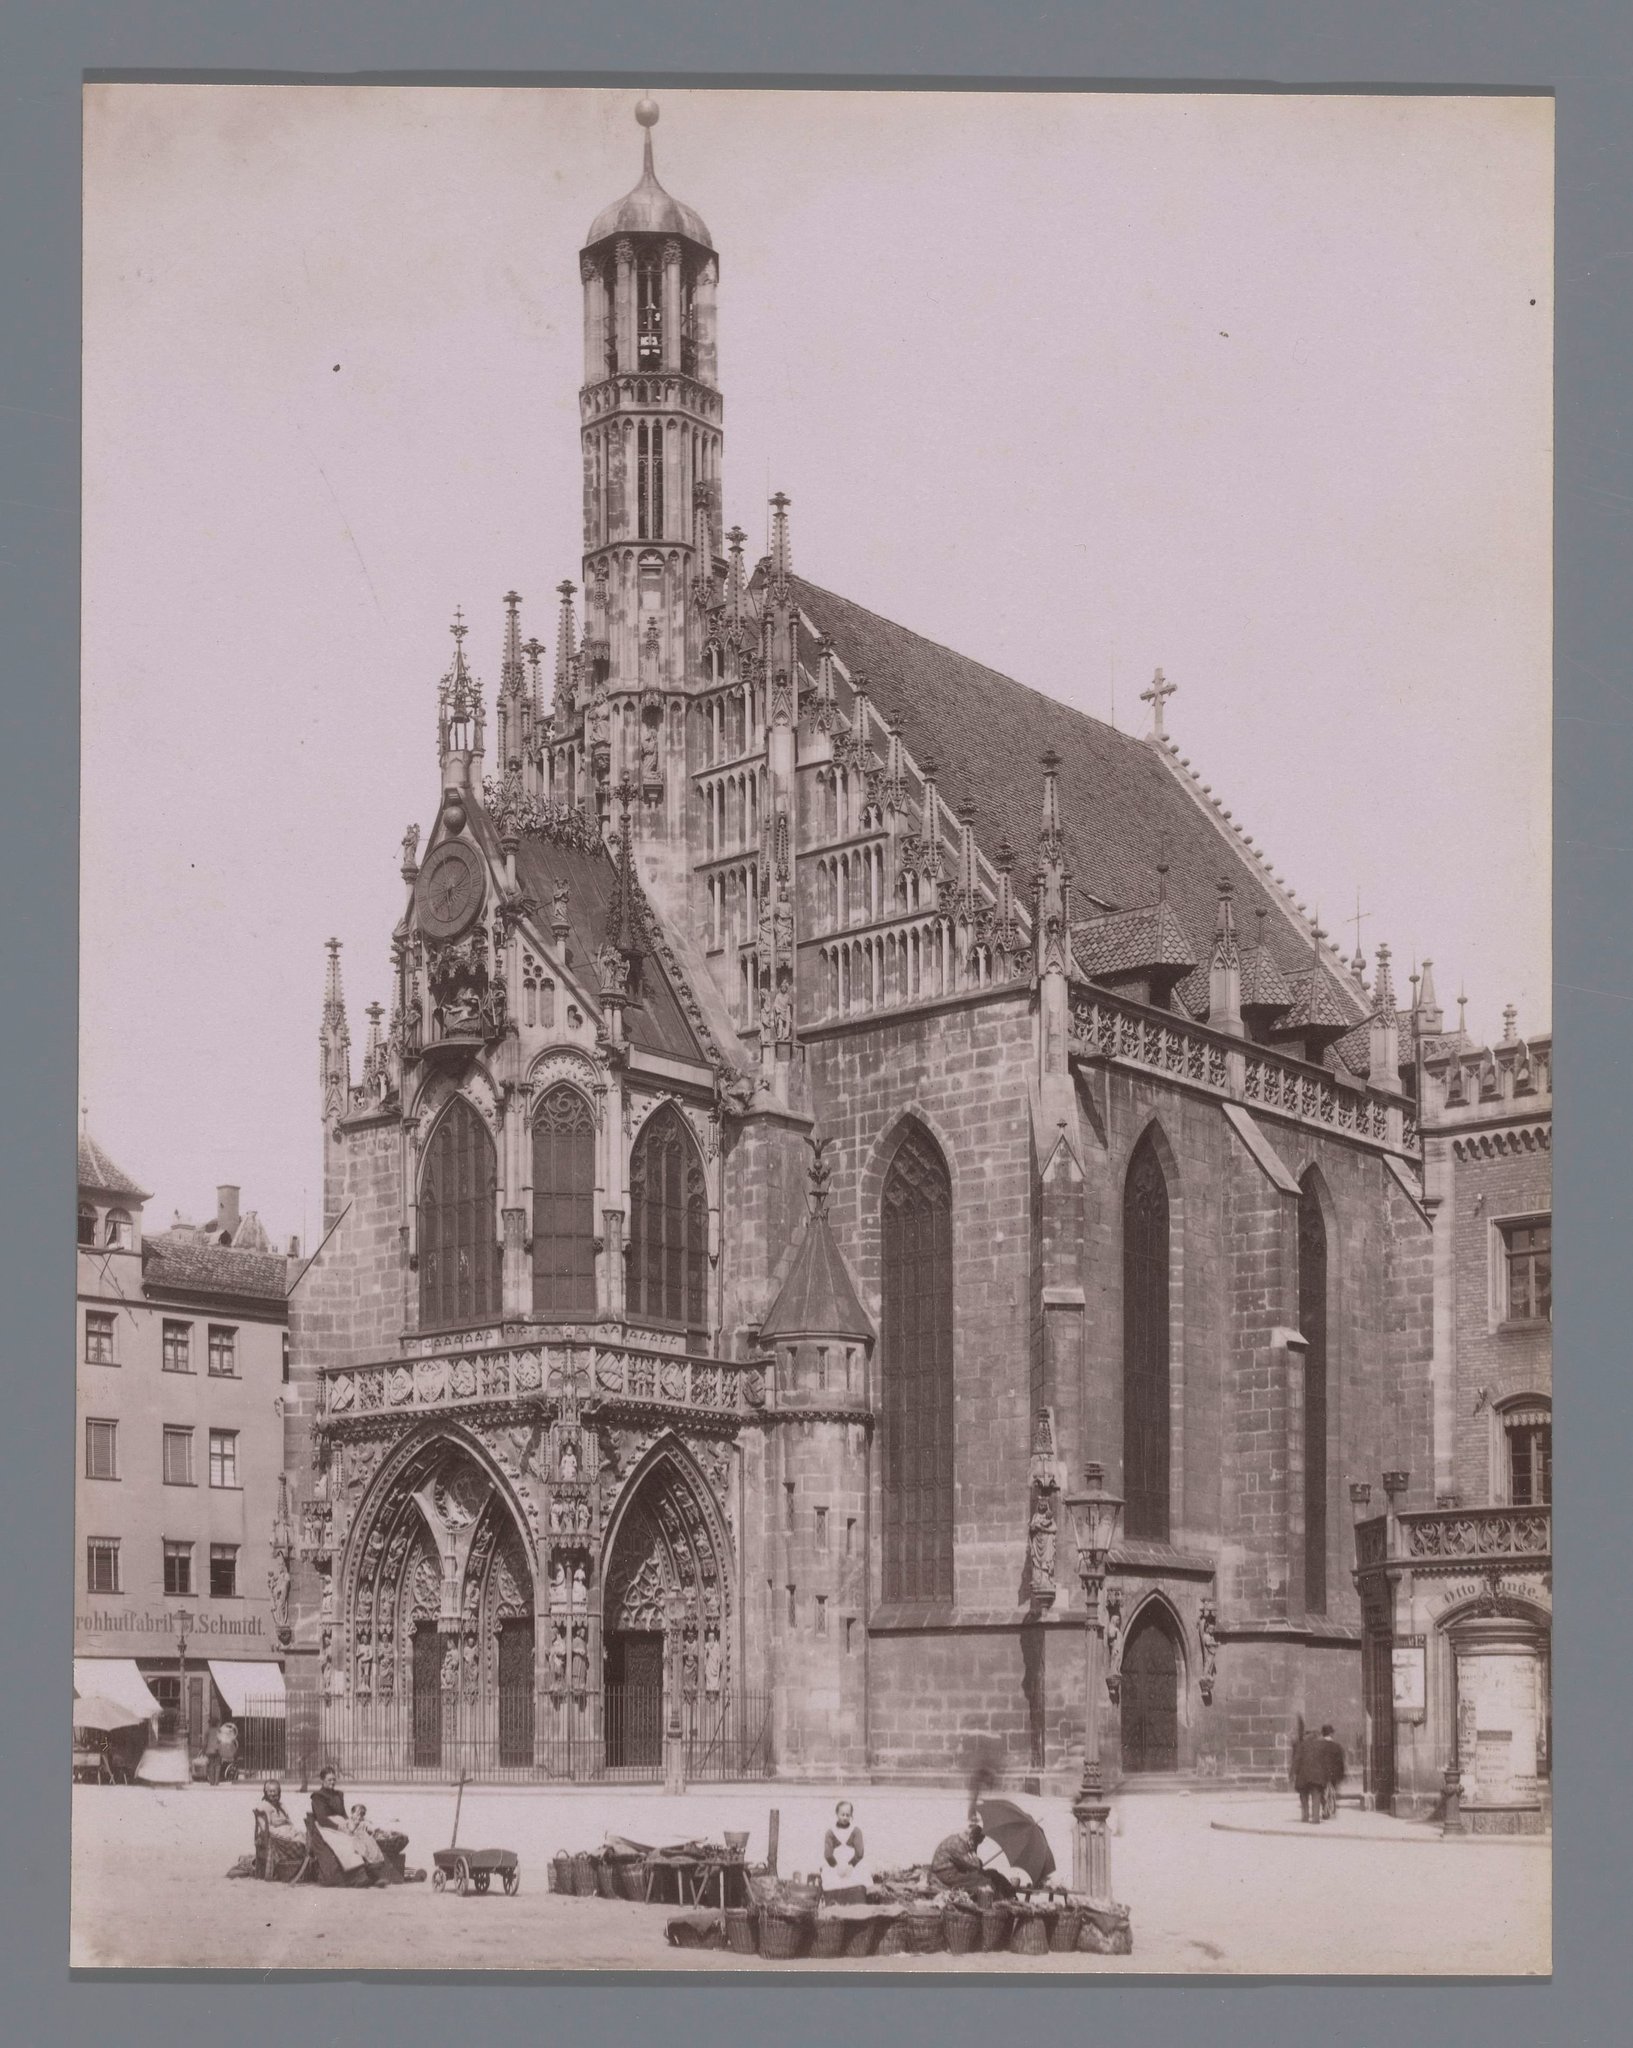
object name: photograph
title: Onze-Lieve-Vrouwekerk in Neurenberg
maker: ferdinand schmidt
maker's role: fotograaf, fotostudio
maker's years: 1840-1909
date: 1895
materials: paper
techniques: albumen print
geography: nuremberg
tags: church (exterior)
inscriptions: check stamp: ‘Ferdinand Schmidt/ Nürnberg 1895’, number: ‘15’, inscription: ‘Nürnberg’